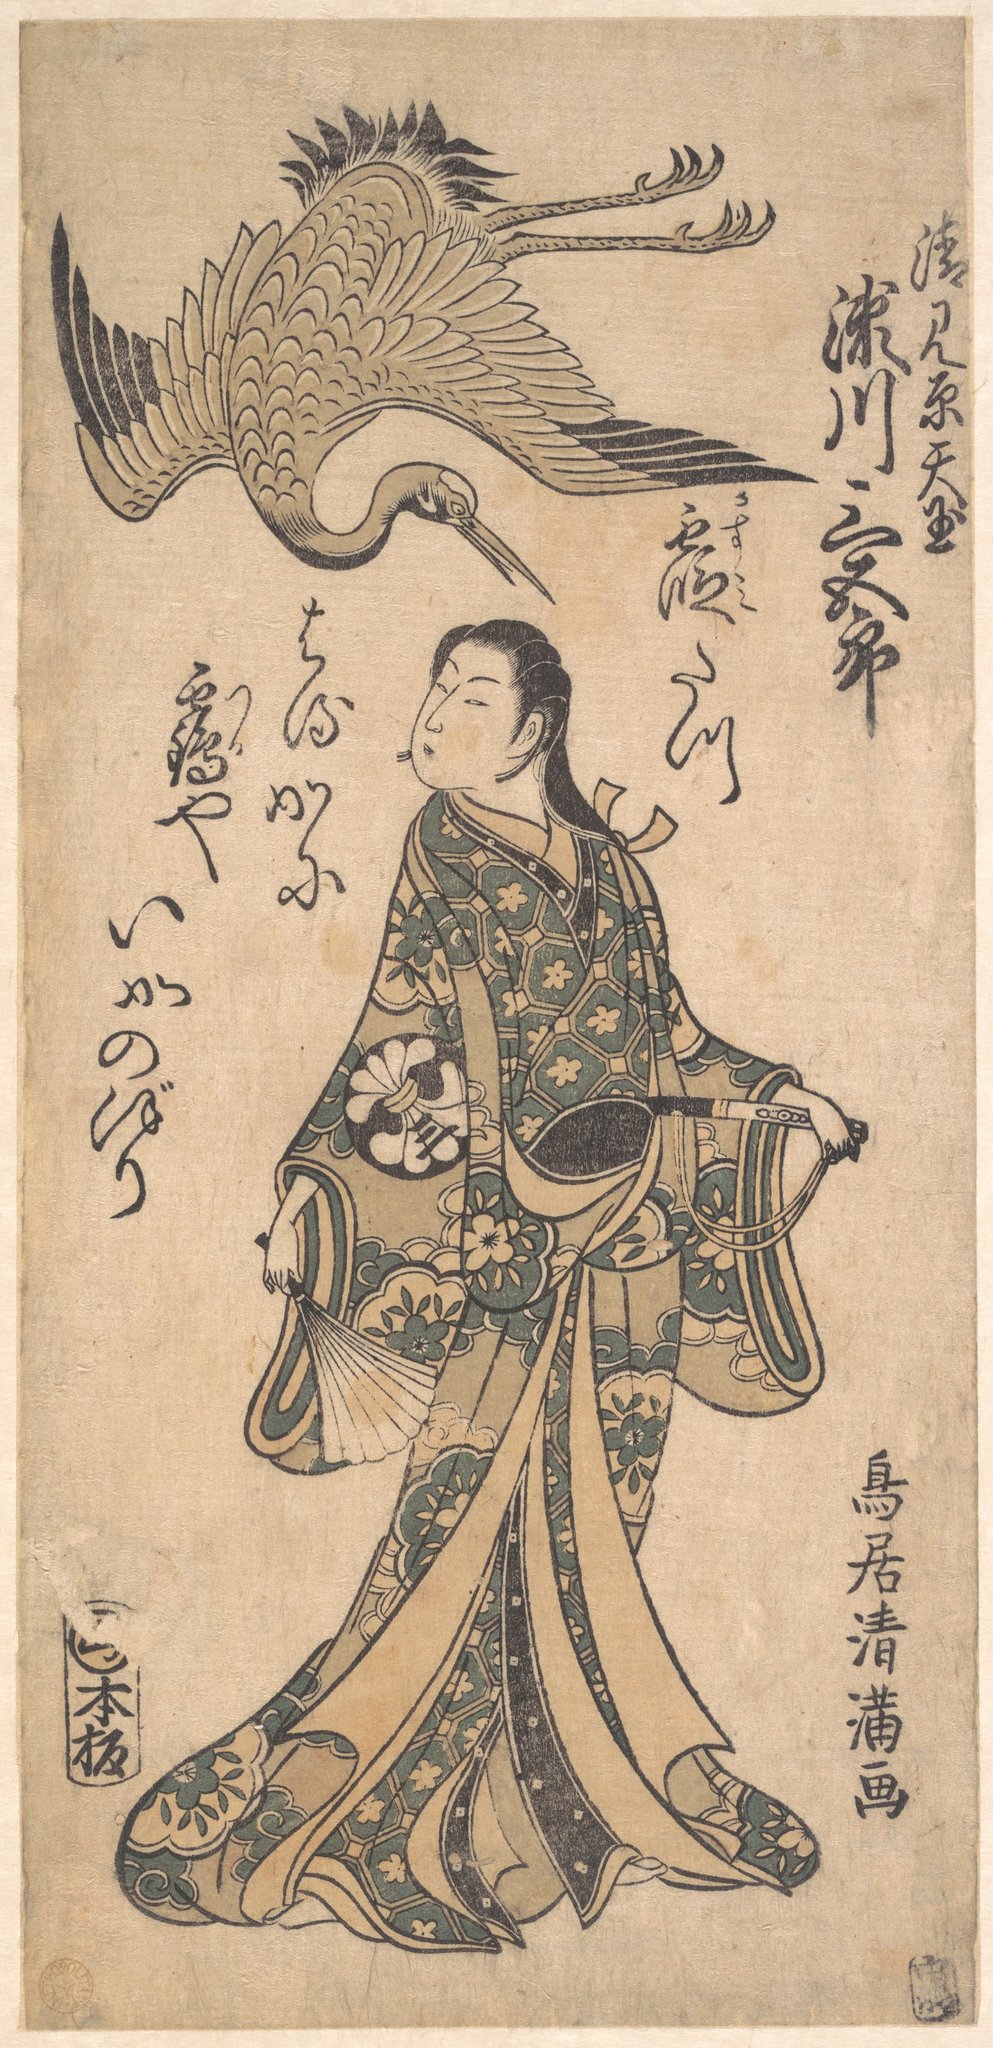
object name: print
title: The Second Segawa Sangoro in the Role of Kiyomihara Tengyoku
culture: japanese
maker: torii kiyomitsu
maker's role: artist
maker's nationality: japanese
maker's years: 1735-1785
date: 1761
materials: ink, paper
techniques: woodblock print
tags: birds,fans,actors